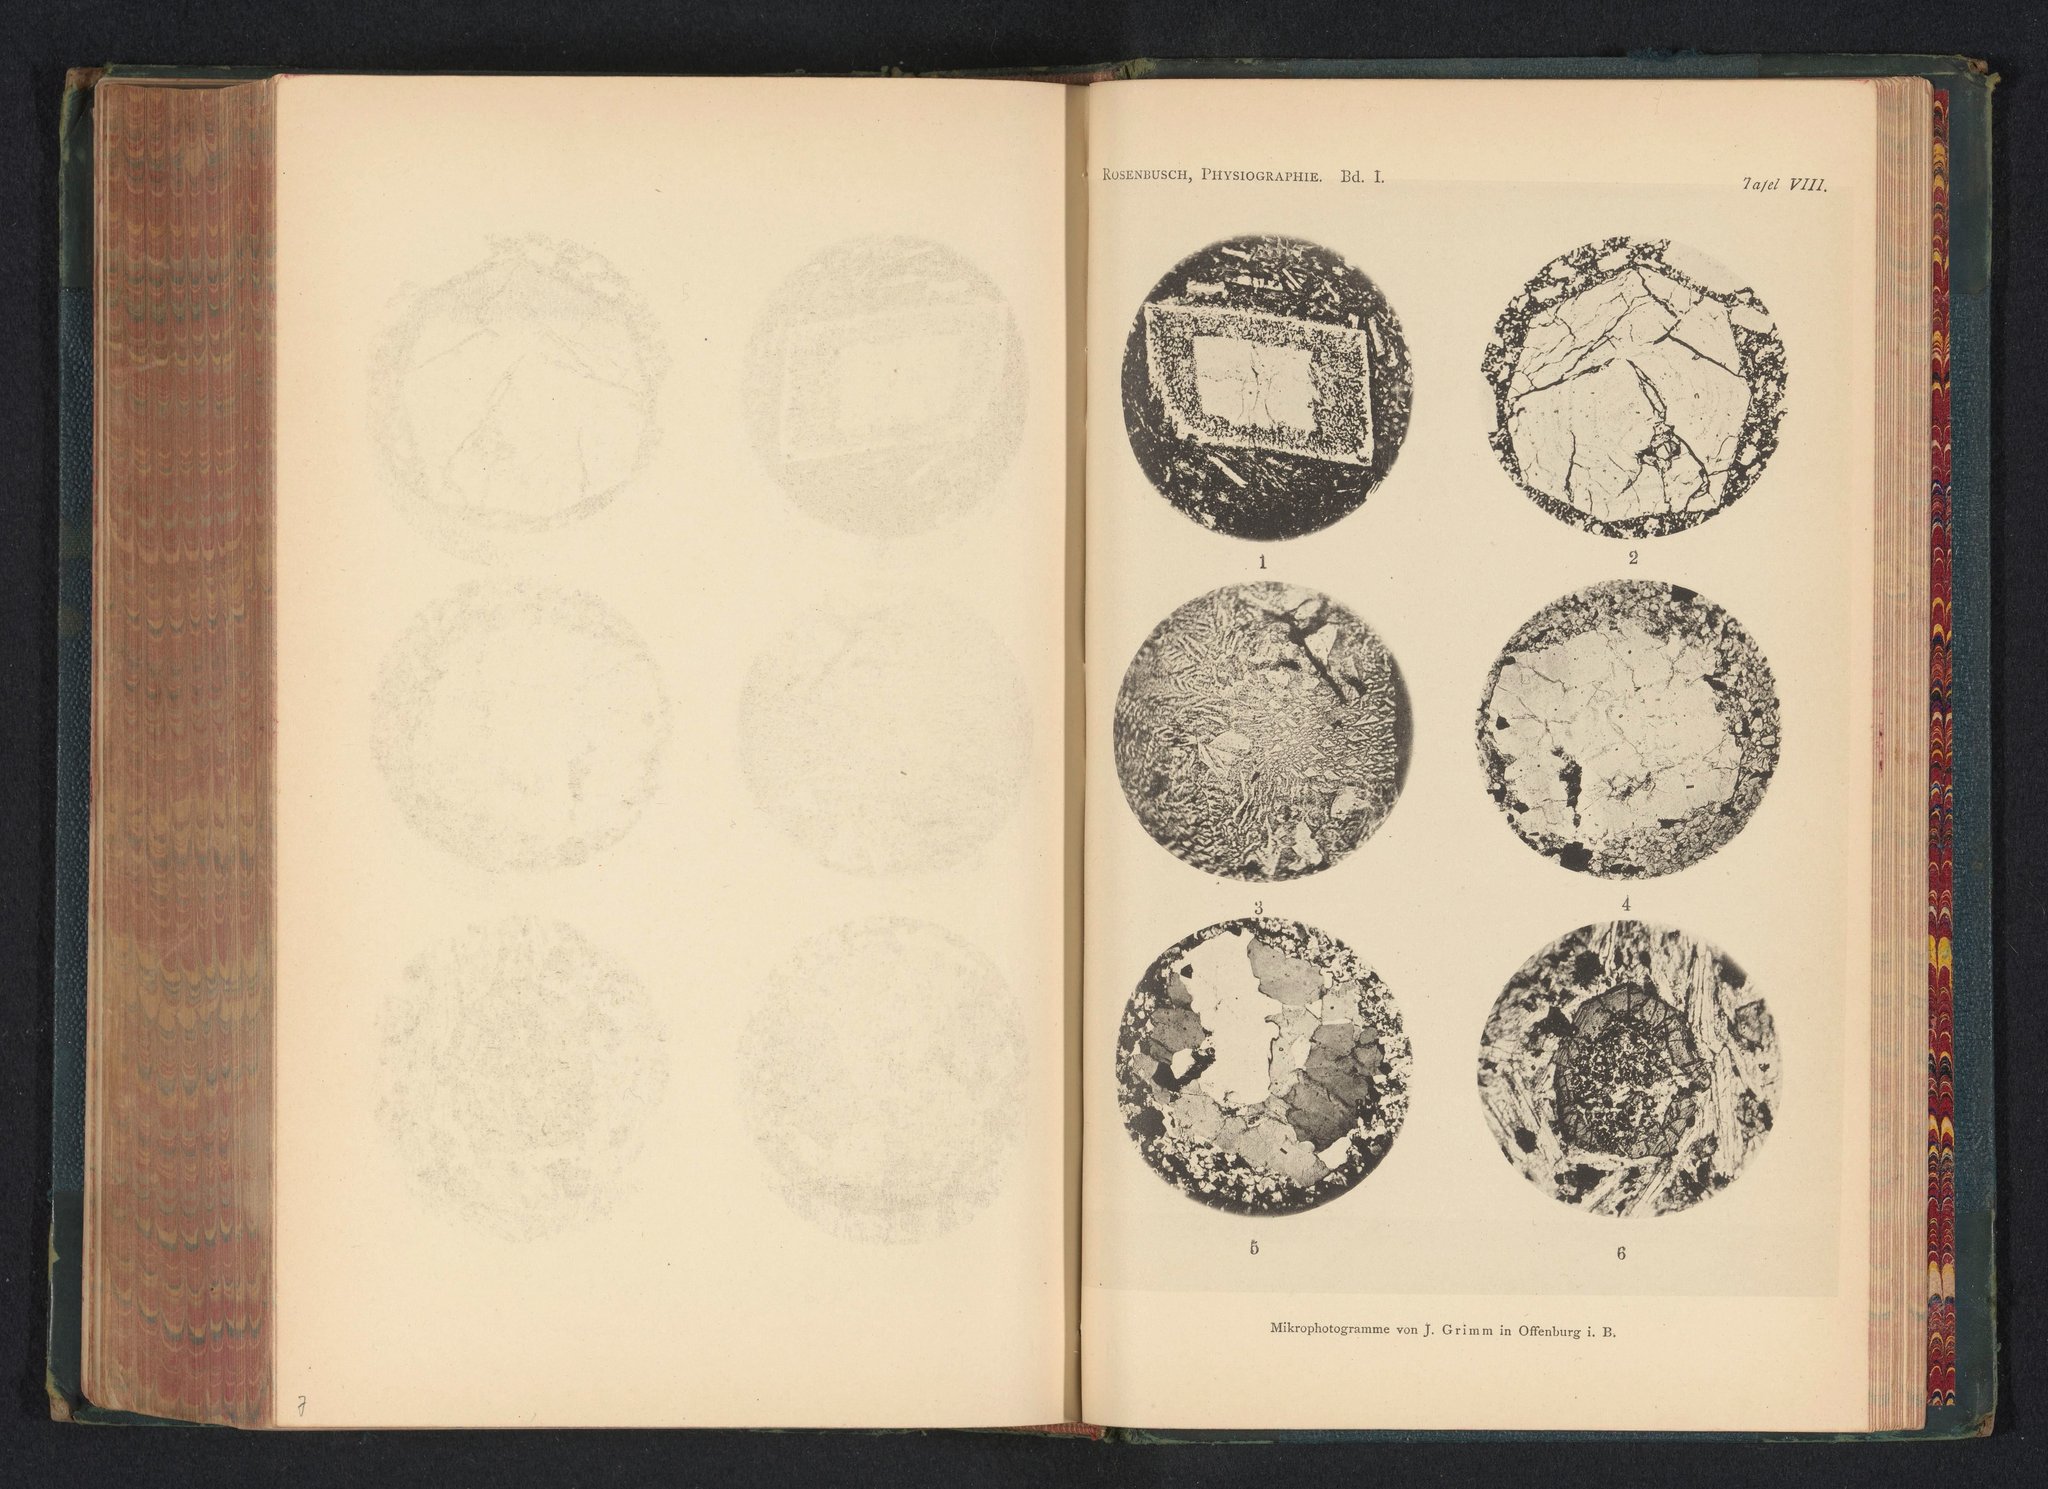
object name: photomechanical print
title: Zes microscopische vergrotingen van mineralen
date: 1880-1885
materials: paper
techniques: photograph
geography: offenburg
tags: minerals and metals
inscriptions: number: ‘1 (...) 6’, number: ‘Tafel VIII’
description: Afbeelding 1 is veldspaat, 2 is leuciet in lava, 3 is granofier, 4 is granietporfier, 5 is granietporfier, en 6 is plagioklaas.